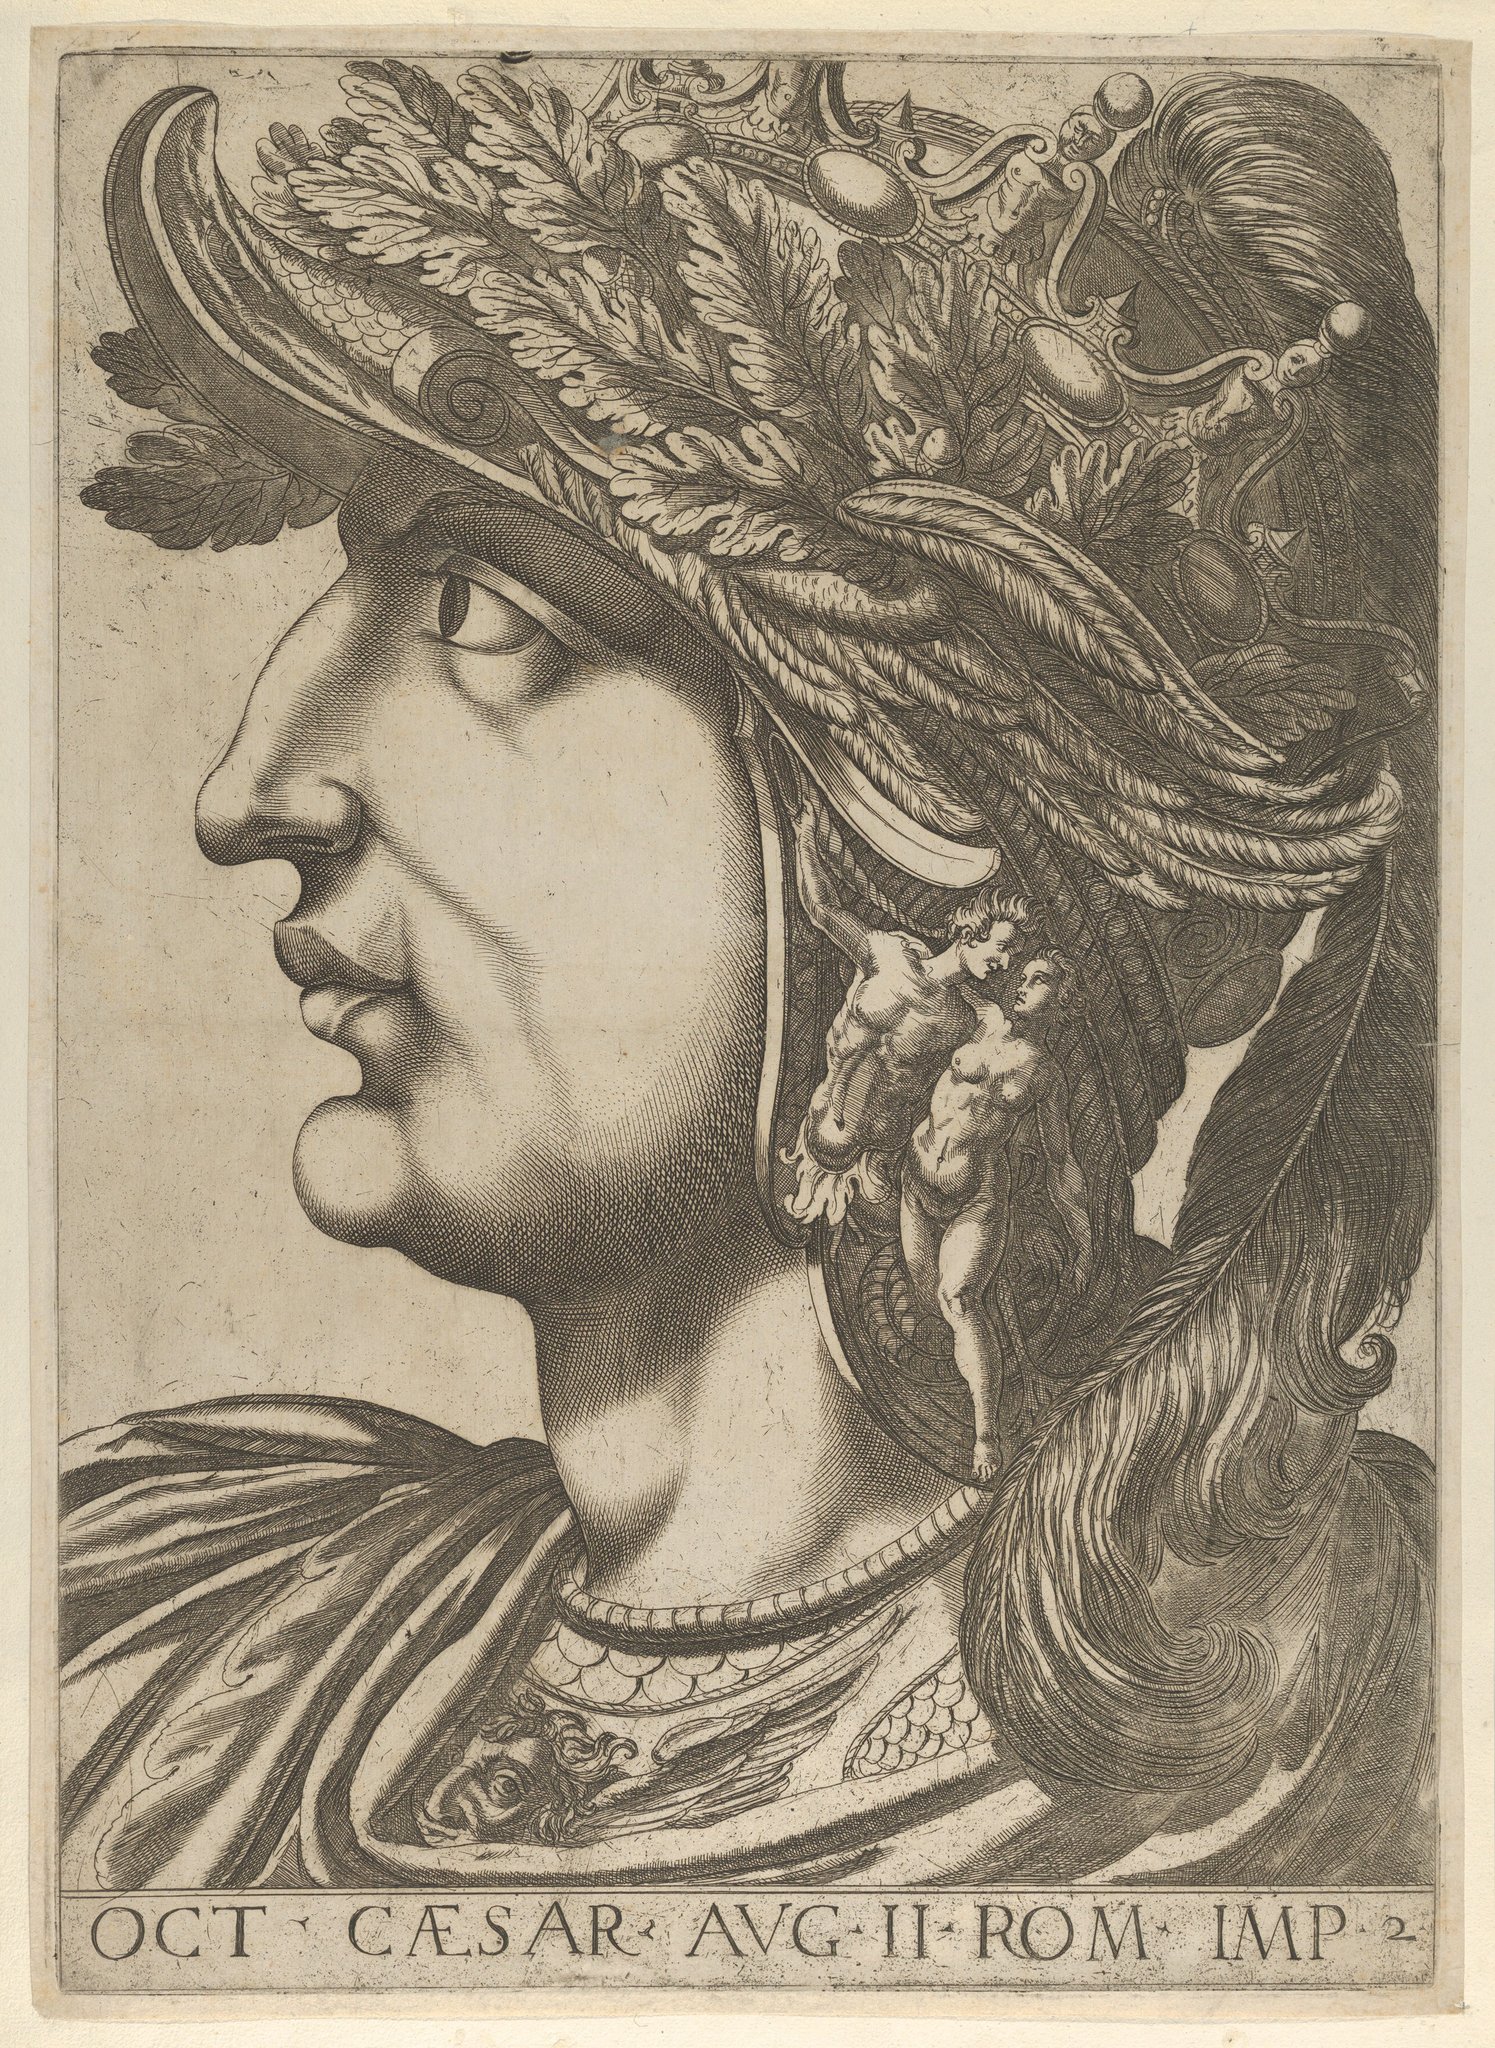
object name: print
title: Plate 2: Octavius in profile to the left, from 'The Twelve Caesars'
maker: Anonymous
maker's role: artist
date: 1610-1640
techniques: engraving, etching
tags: men,male nudes,profiles,female nudes